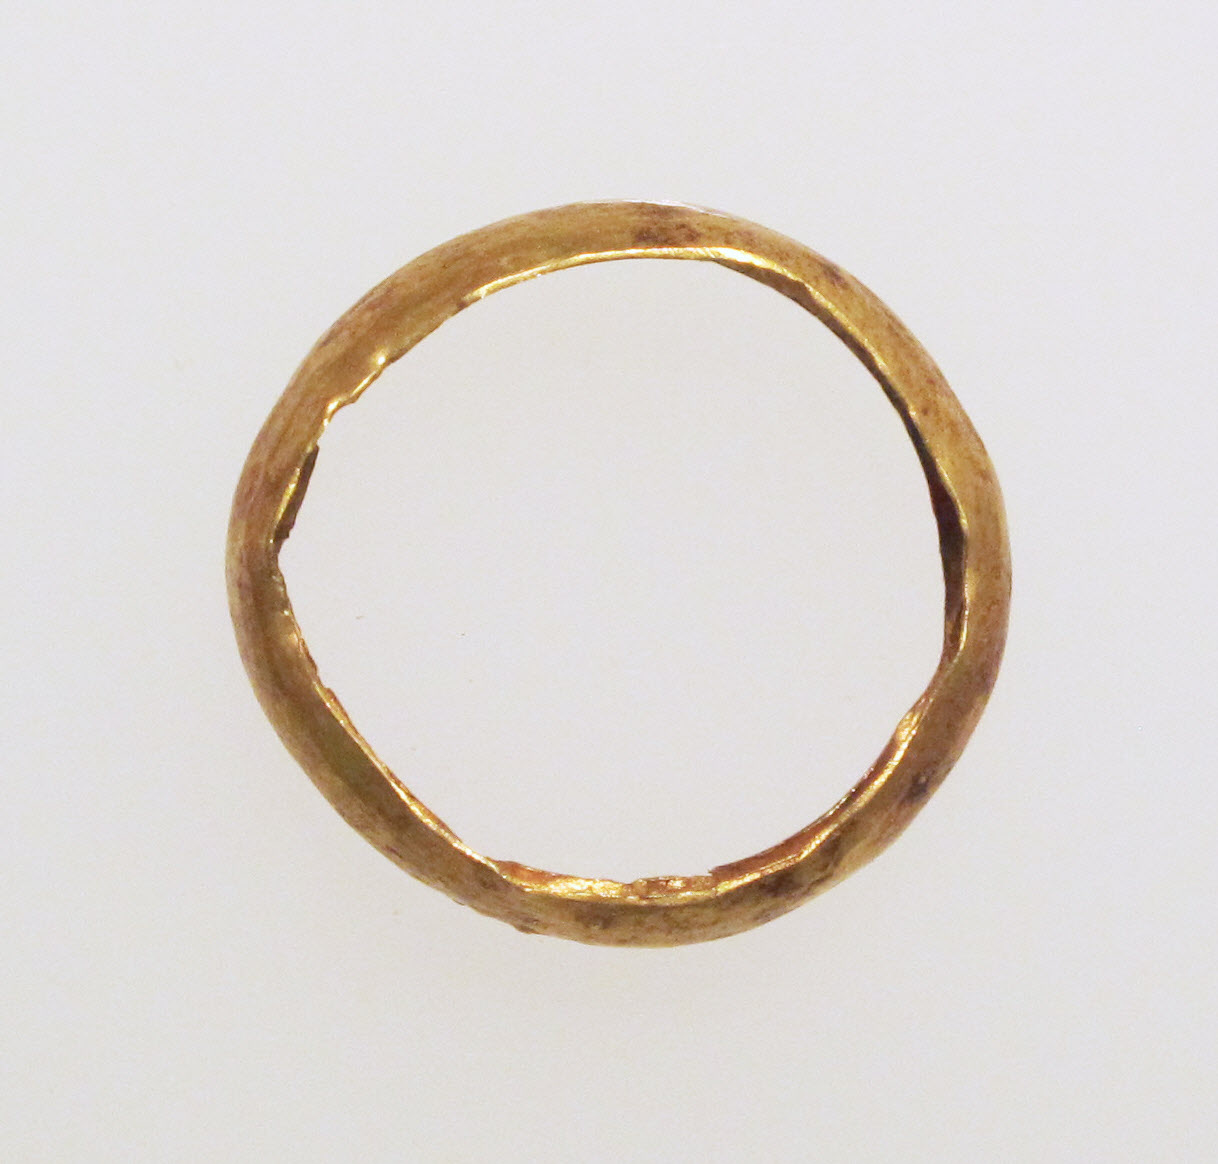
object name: ring with hollow hoop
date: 7000 BCE-330 CE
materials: gold